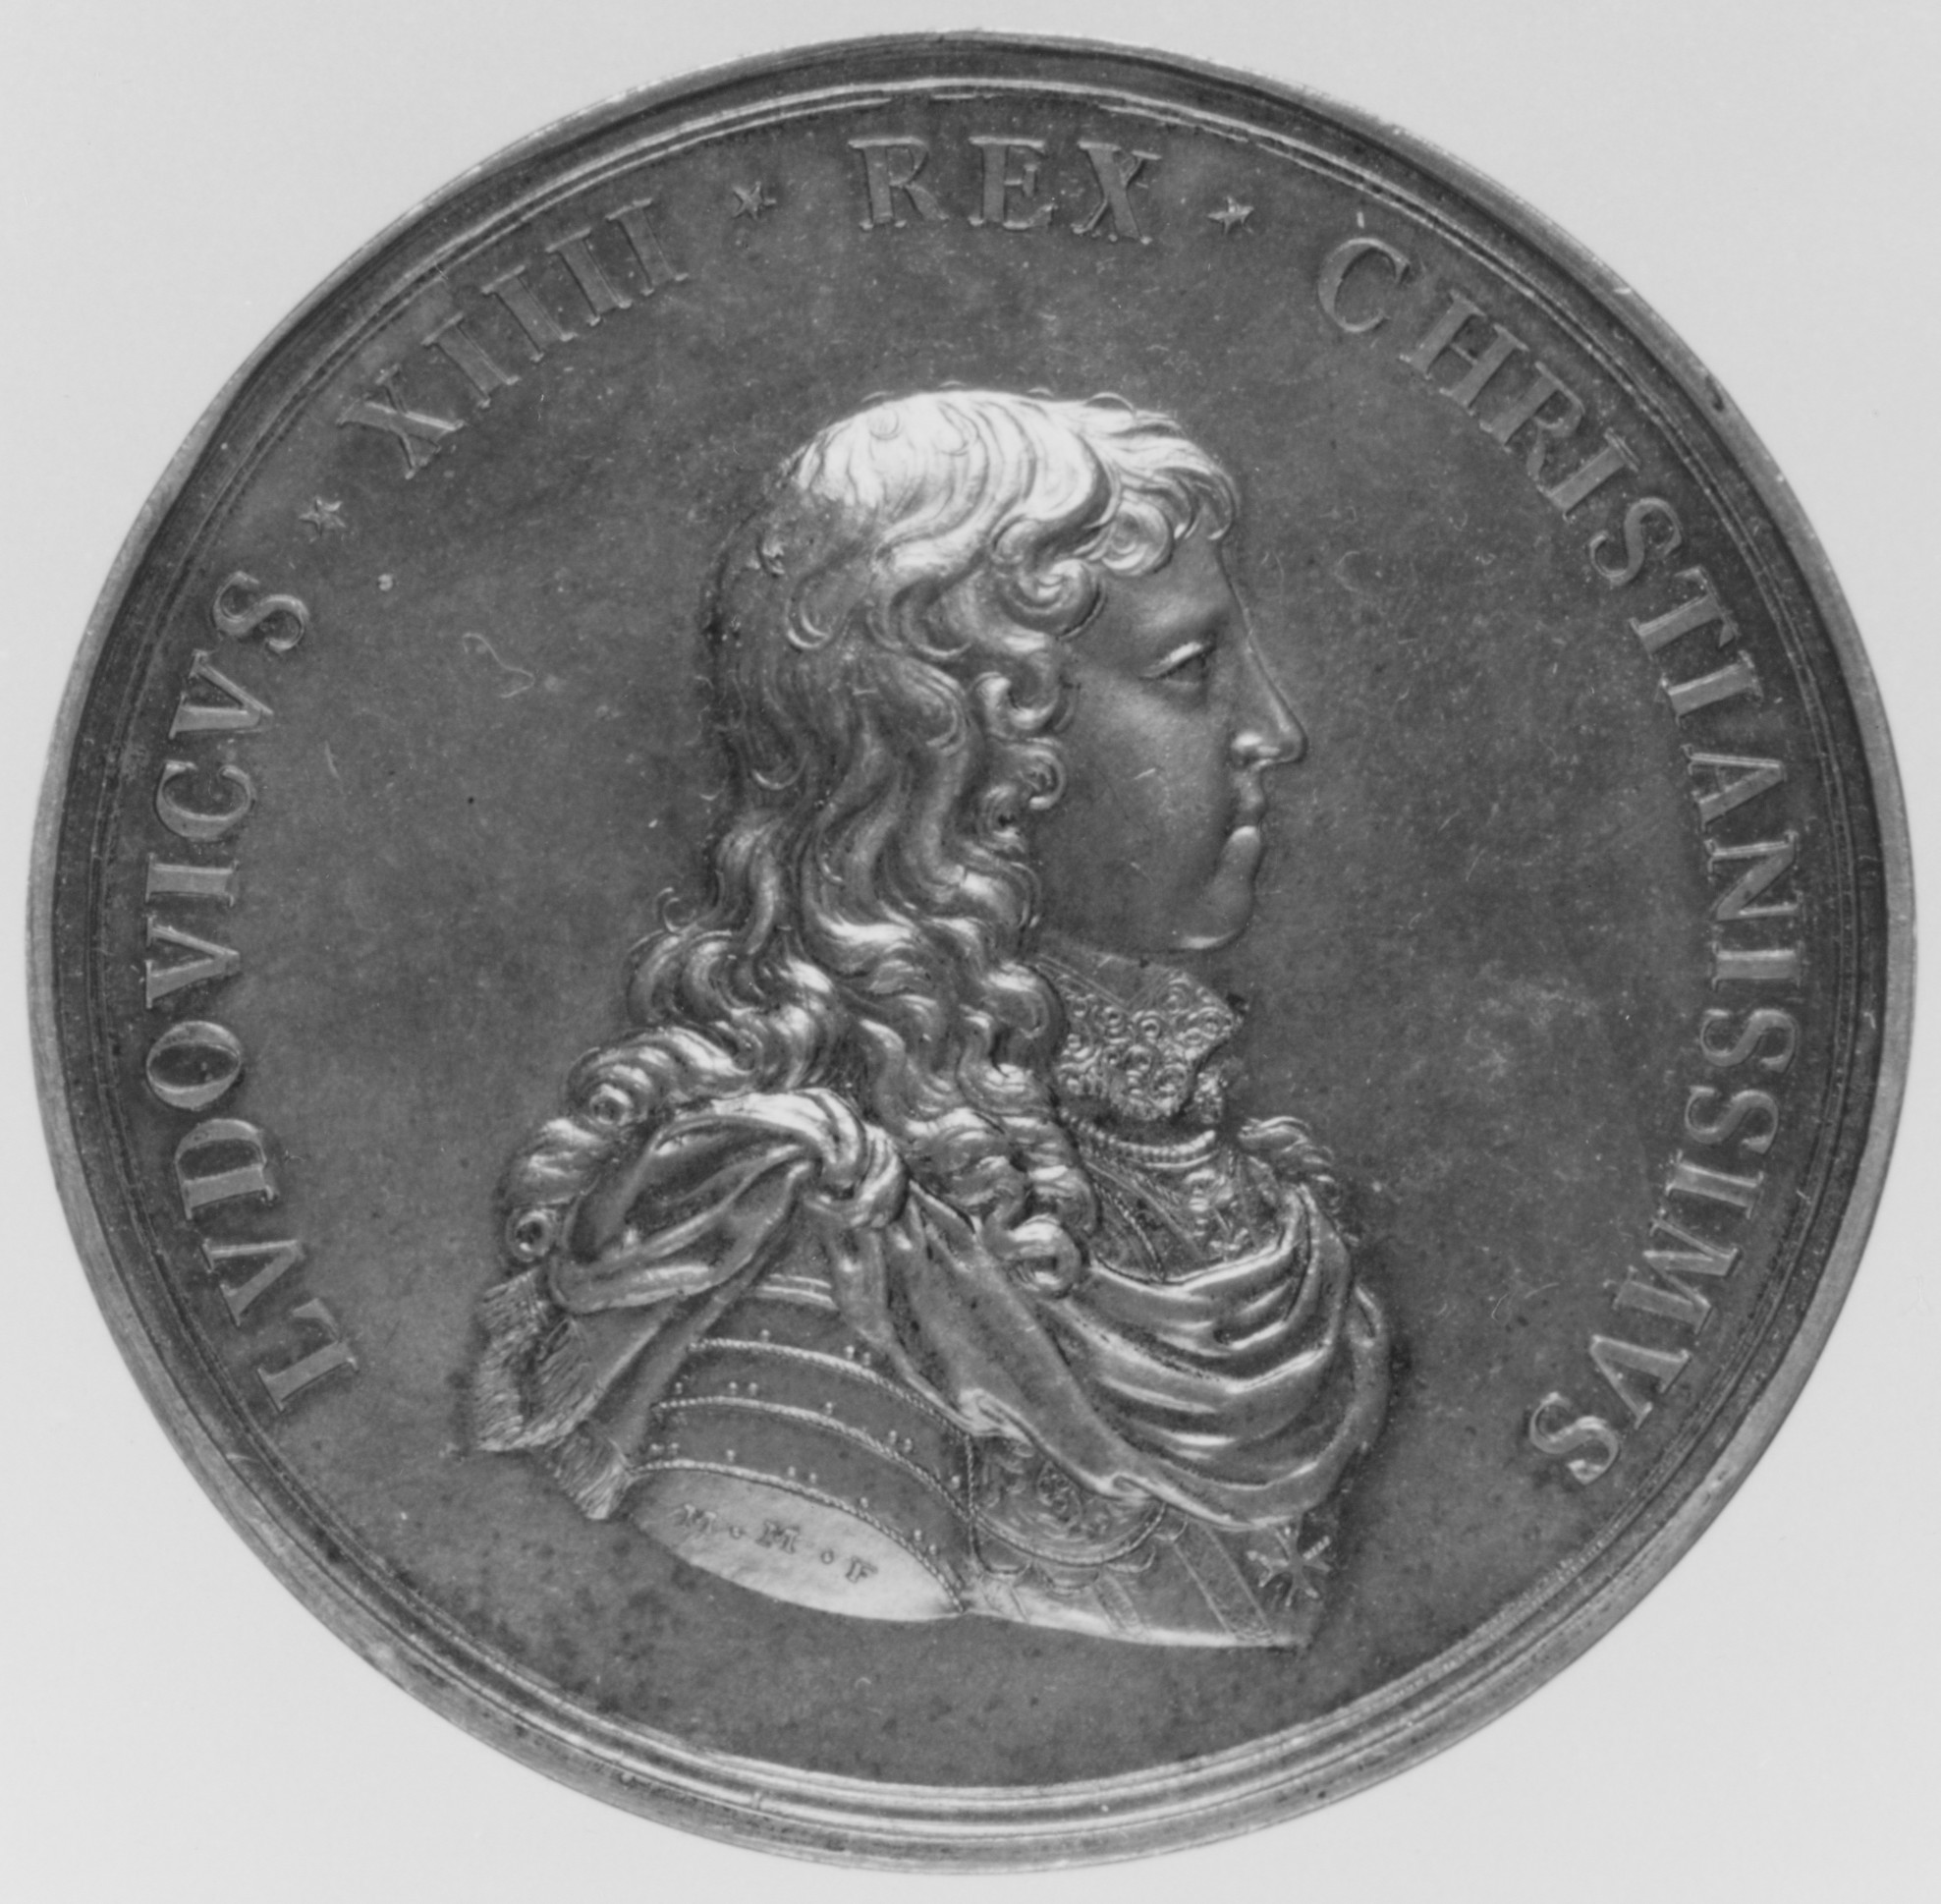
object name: medal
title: Louis XIV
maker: michel molart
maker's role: artist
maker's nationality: french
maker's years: 1641-1713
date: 1643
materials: bronze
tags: buildings,louis xiv,profiles